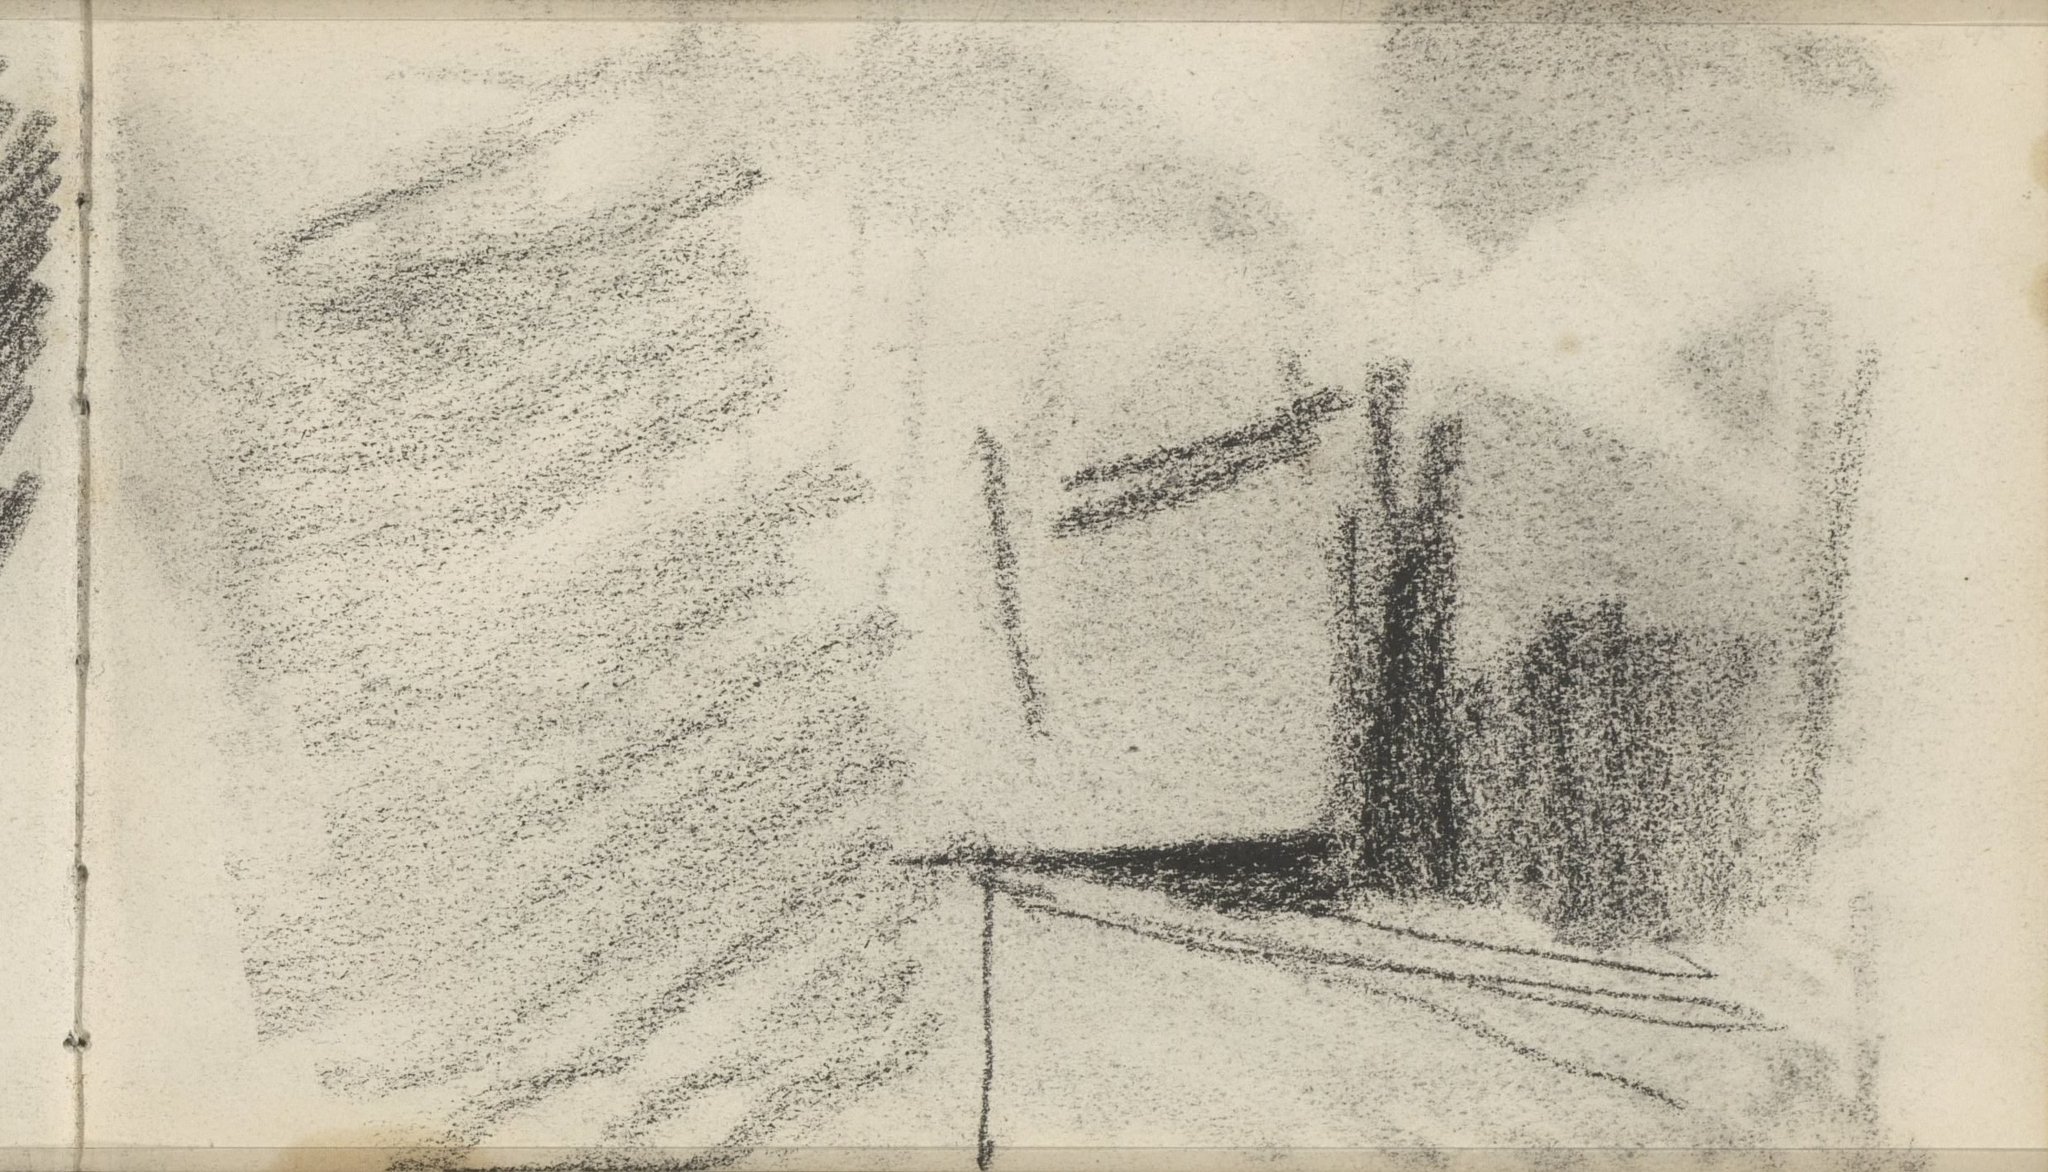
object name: sketchbook leaf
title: Studie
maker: george hendrik breitner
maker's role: draughtsman, painter, print maker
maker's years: 1857-1923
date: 1883-1885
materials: chalk, paper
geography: drenthe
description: Pagina 94 uit een schetsboek met 48 bladen.